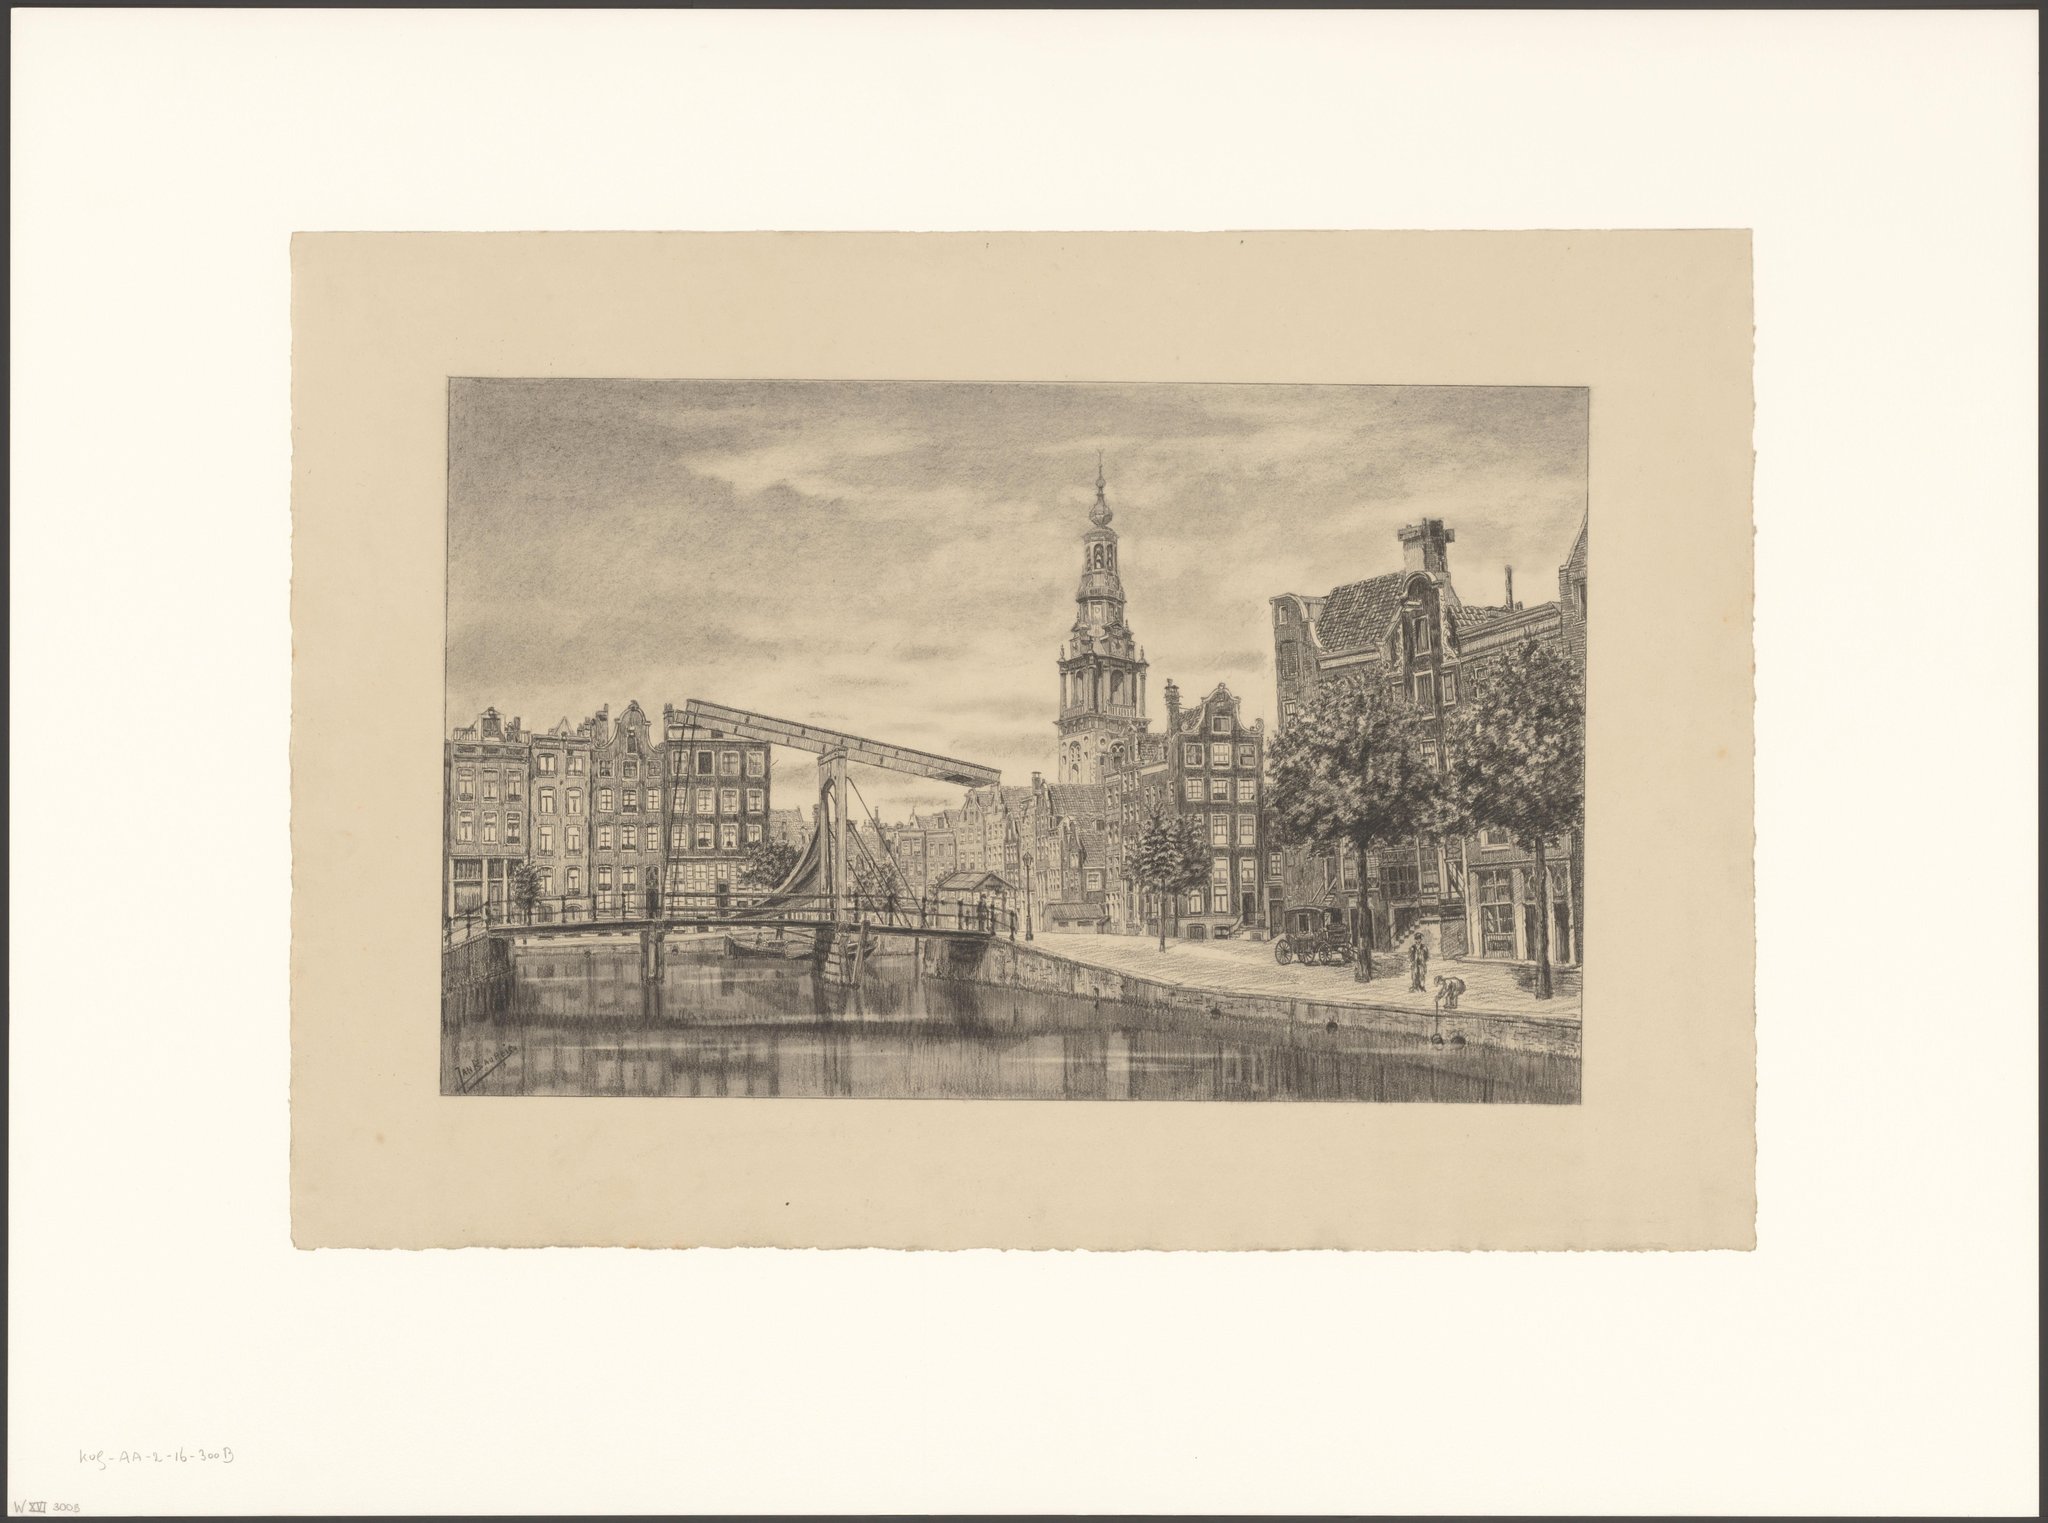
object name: drawing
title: Gezicht op de Houtgracht gezien naar de Zuidertoren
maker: jan baureis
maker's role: draughtsman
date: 1850-1882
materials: chalk, paper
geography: amsterdam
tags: city-view in general; 'veduta', canal, parts of church exterior and annexes: spire, bridge in city across river, canal, etc., street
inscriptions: signature: ‘Jan Baureis’, collector's mark: Lugt 800a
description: Tekening binnen de Atlas Van Eck ingedeeld op wijknummer 16.